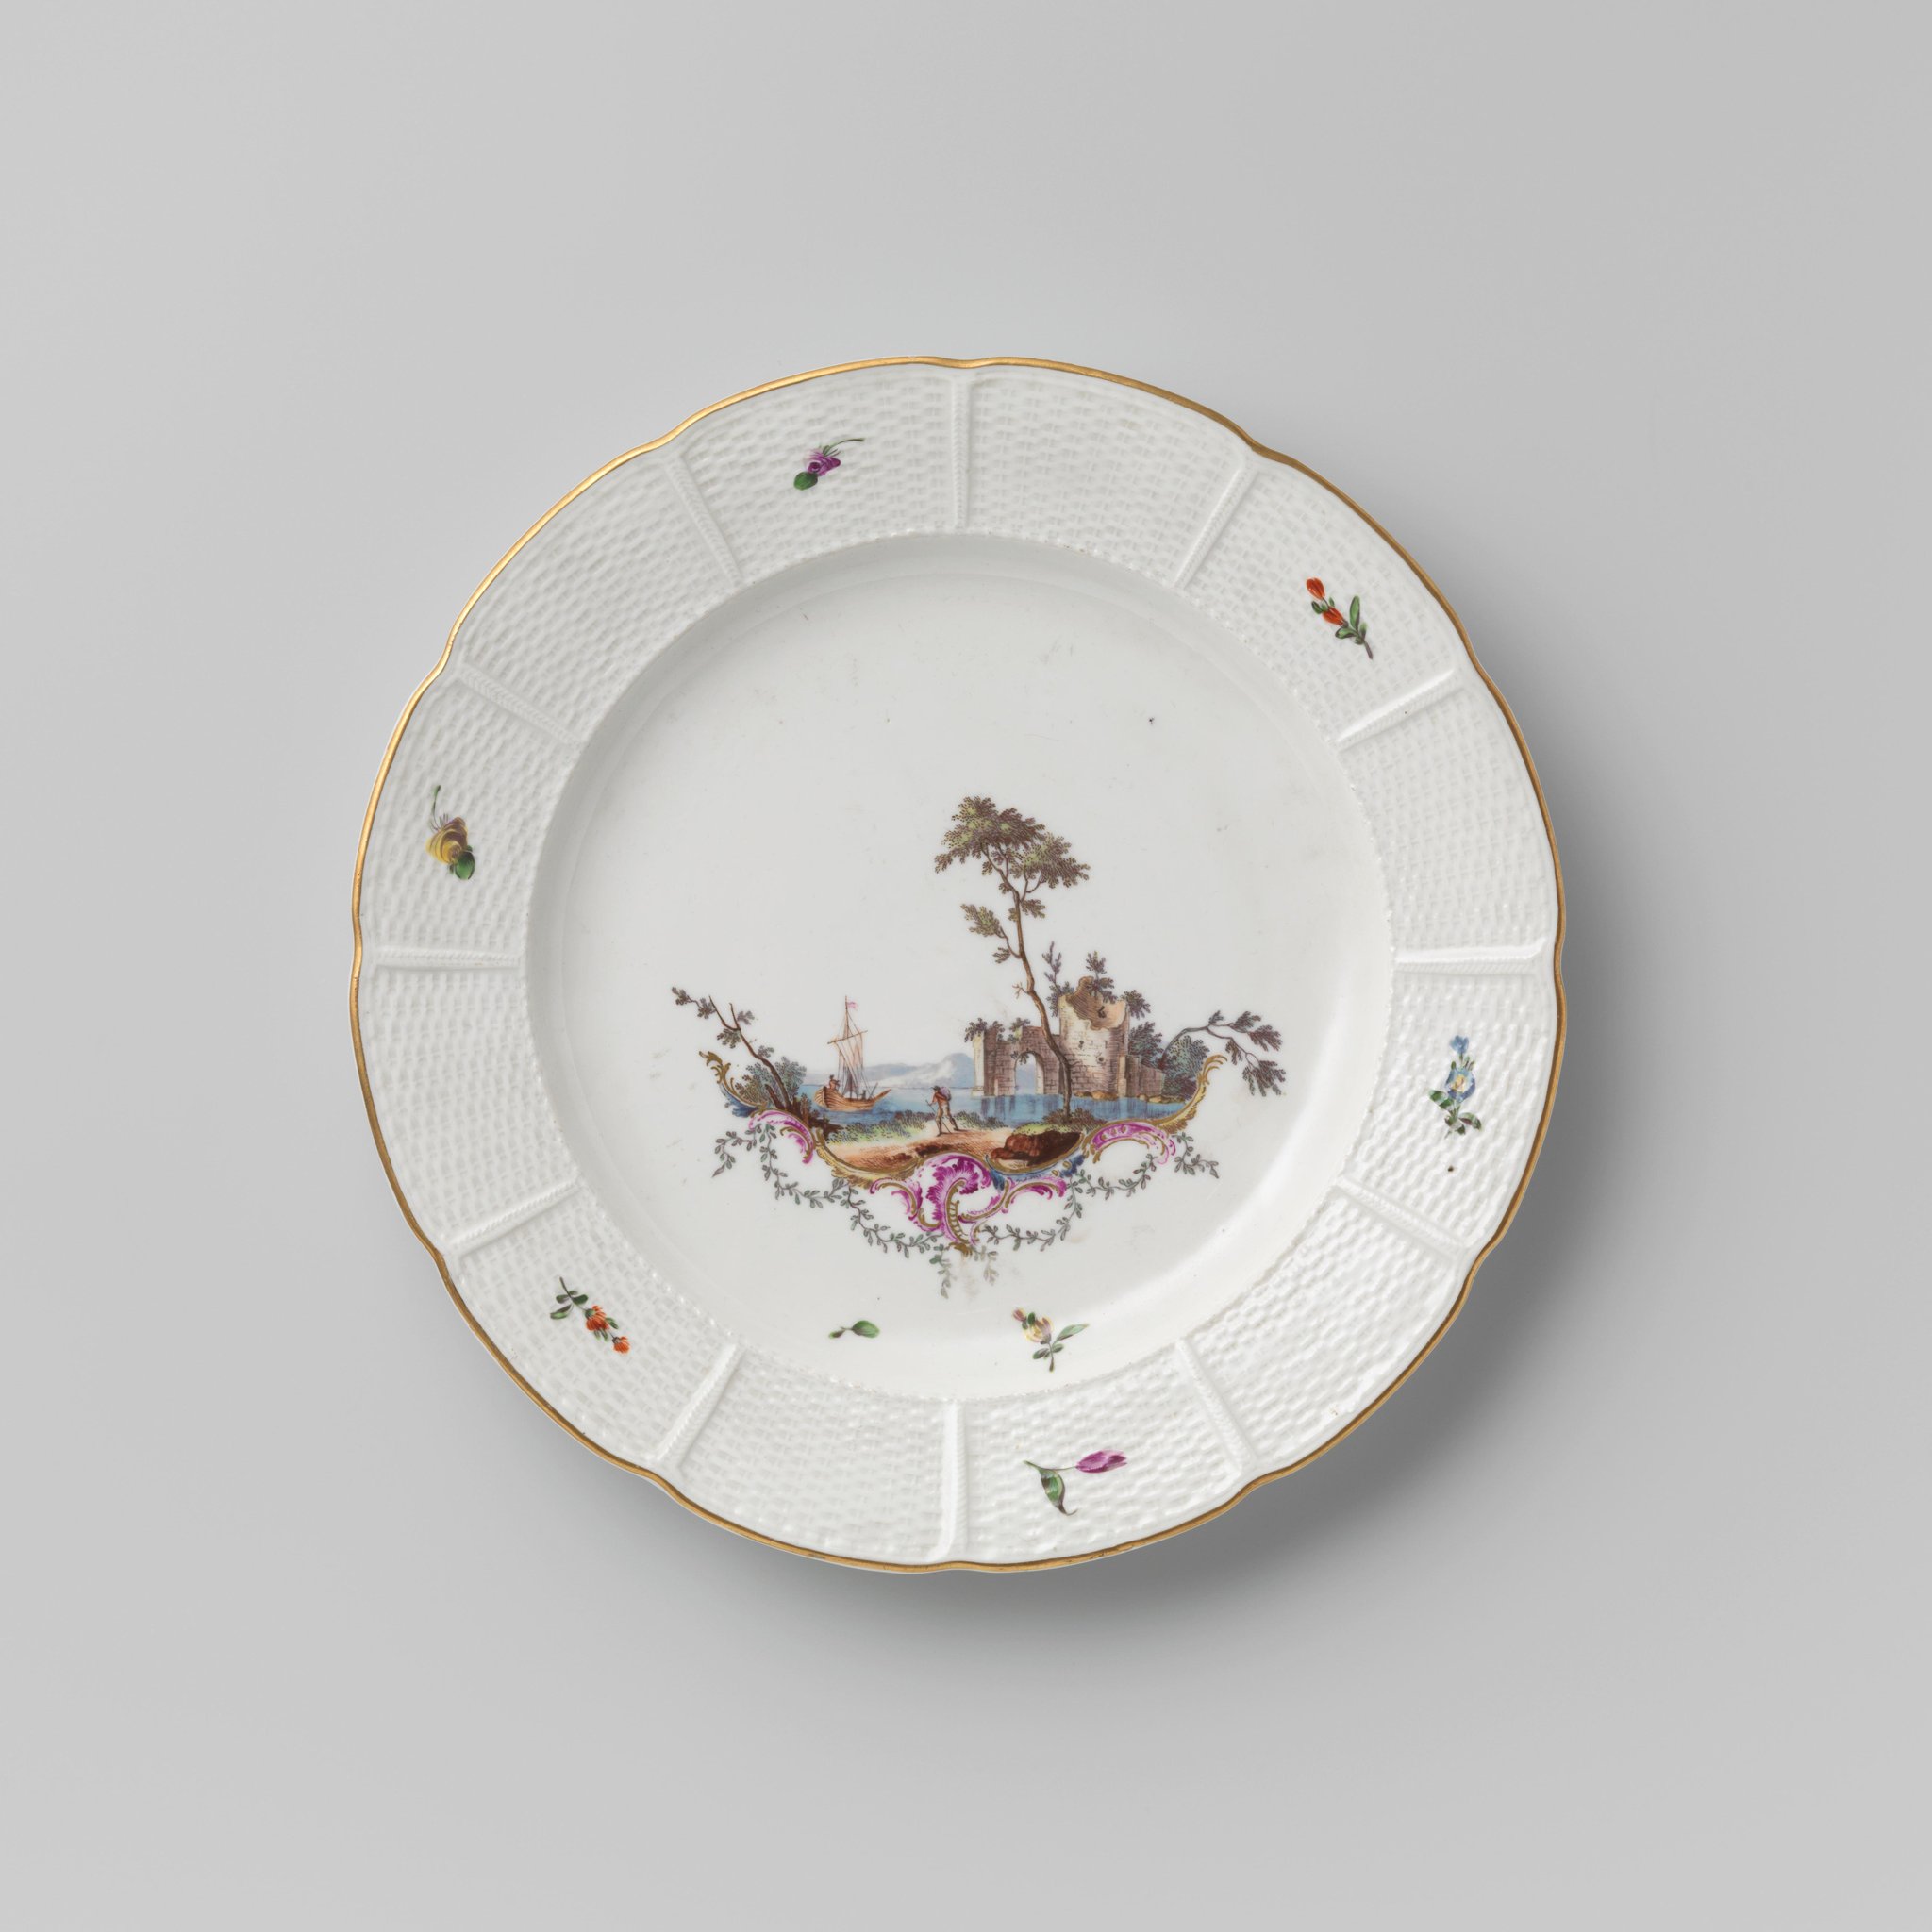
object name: plate dish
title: Plate with a water landscape and flowers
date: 1760-1800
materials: glaze, gold, paint, porcelain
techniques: firing, forming, gilding, relief, vitrification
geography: ludwigsburg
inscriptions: mark: ‘gekroonde dubbele C/ A’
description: Bord van porselein met een gelobde rand, beschilderd op het glazuur in emailkleuren en goud. Op het plat een rivierlandschap met een persoon met een wanderstok, een ruïne en een boot op het water. Onder het landschap rocailles en een guirlande. De rand is gemodelleerd in vakken met vlechtwerk, waarop om het vak een strooibloem. Gouden rand. Gemerkt op de onderzijde met de gekroonde dubbele C en een A.